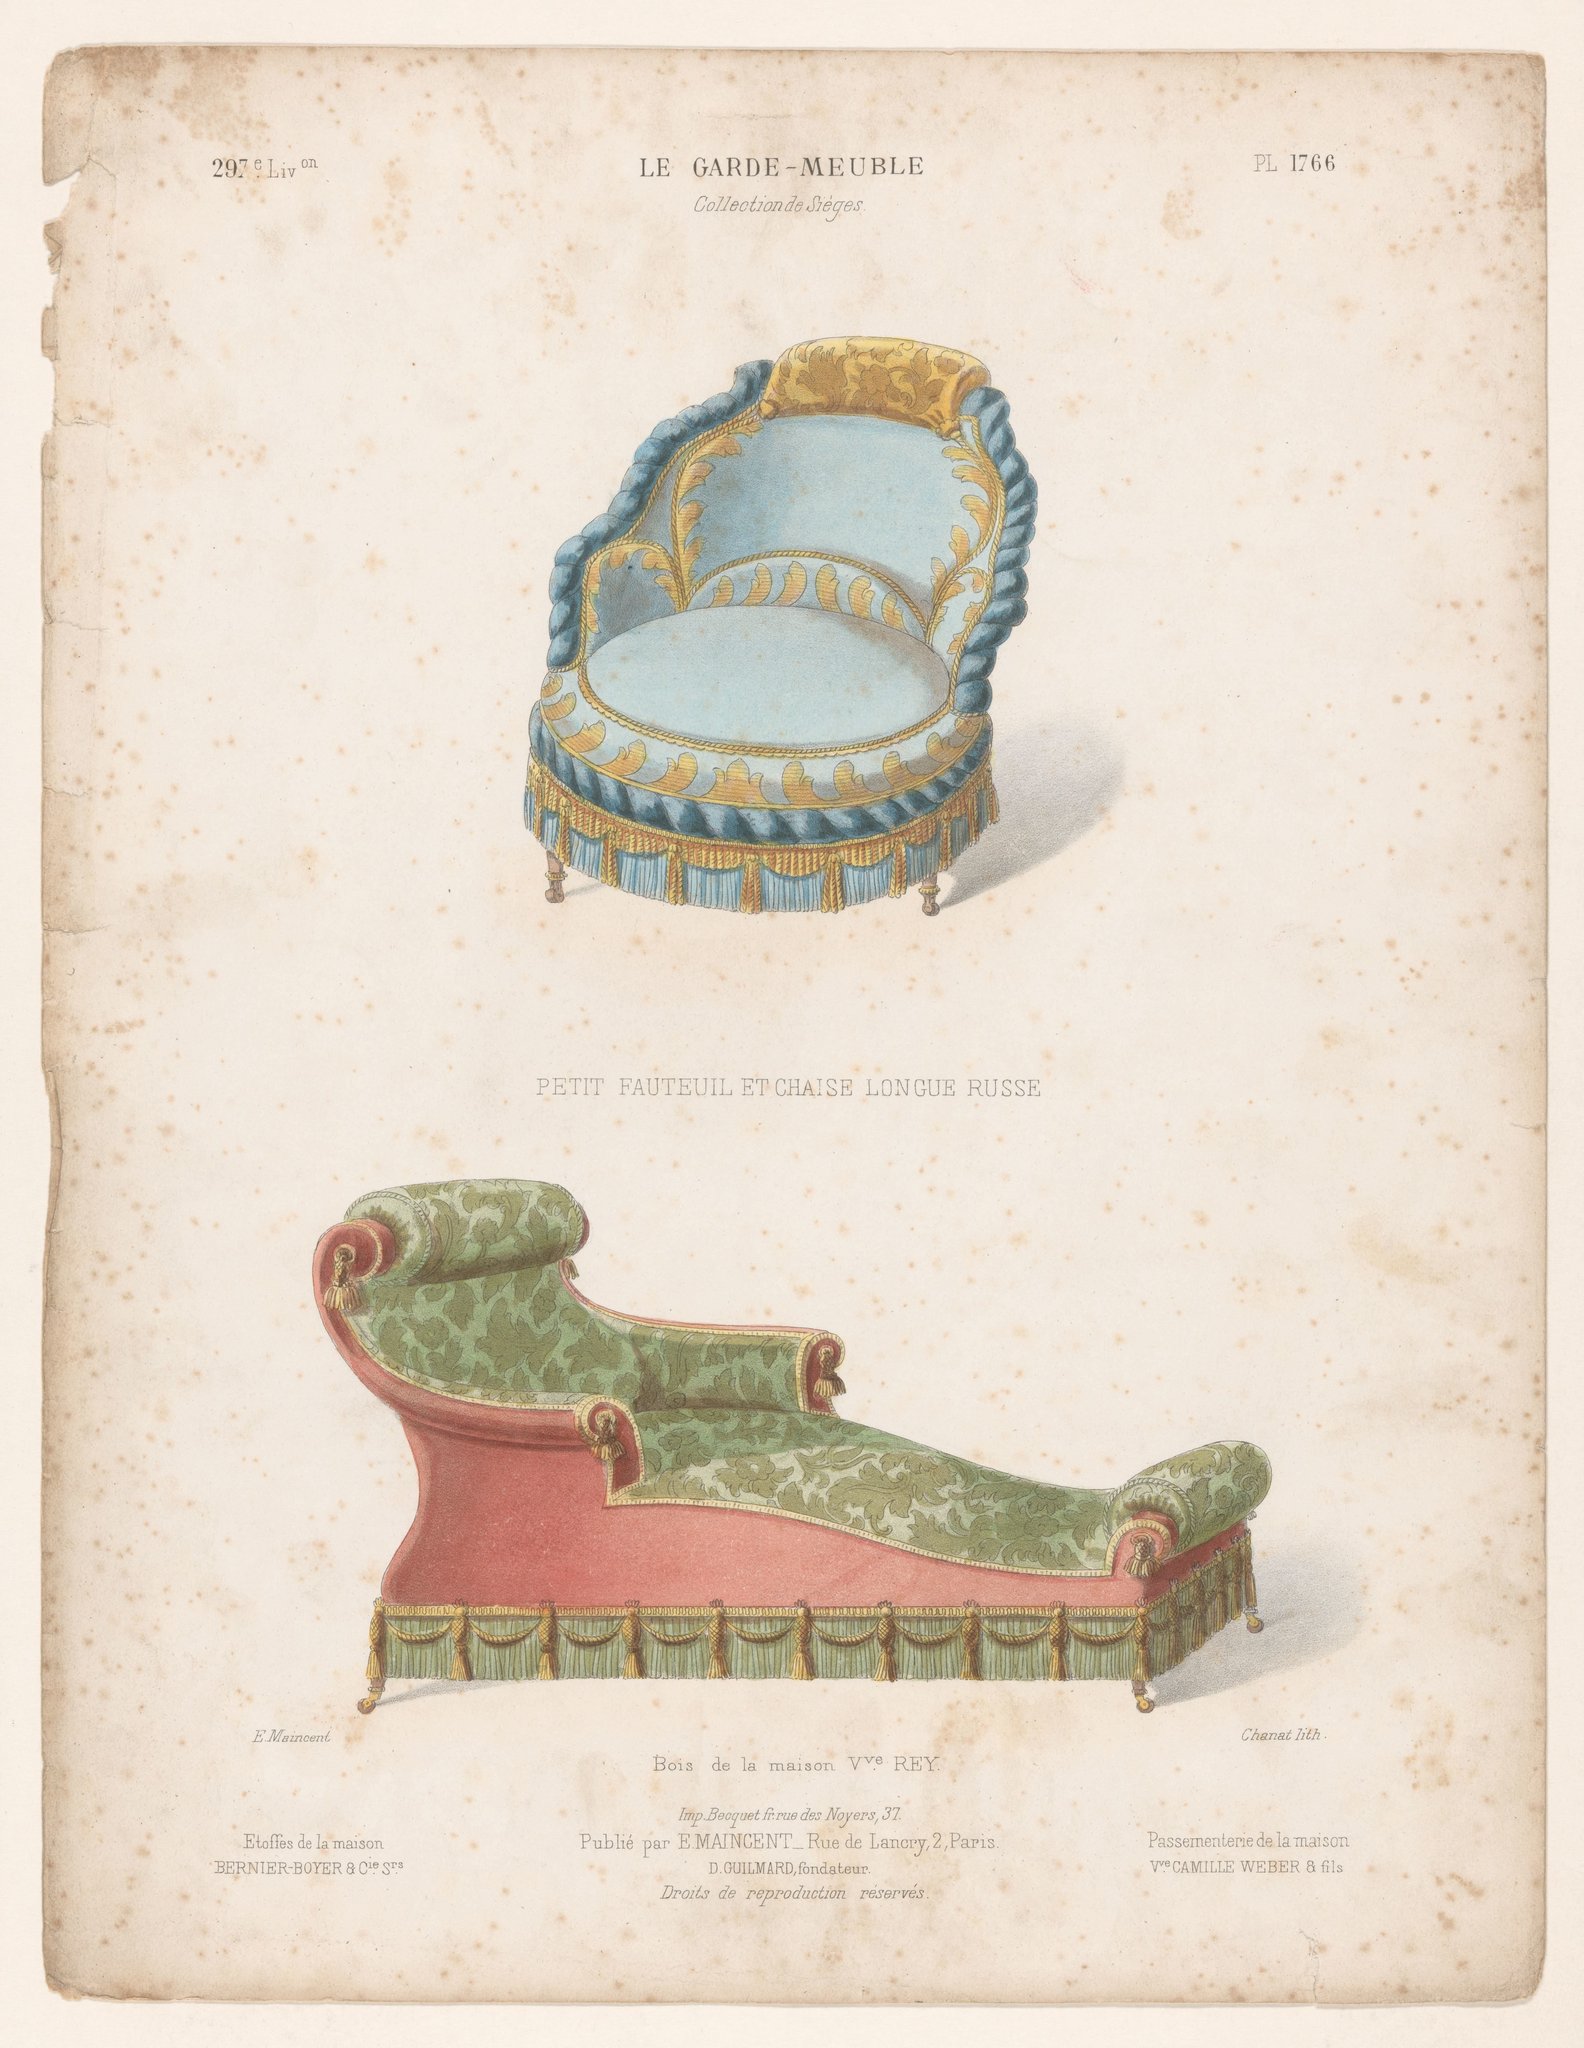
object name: print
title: Fauteuil en chaise longue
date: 1885-1895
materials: paper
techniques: hand coloring, lithograph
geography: paris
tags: seating furniture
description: Ieder Livraison in de serie Le Garde-Meuble bevat negen platen: drie 'sièges' (zitmeubels), drie 'meubles' (diverse meubels zoals tafels en kasten) en drie 'tentures' (gordijnen en draperieën).